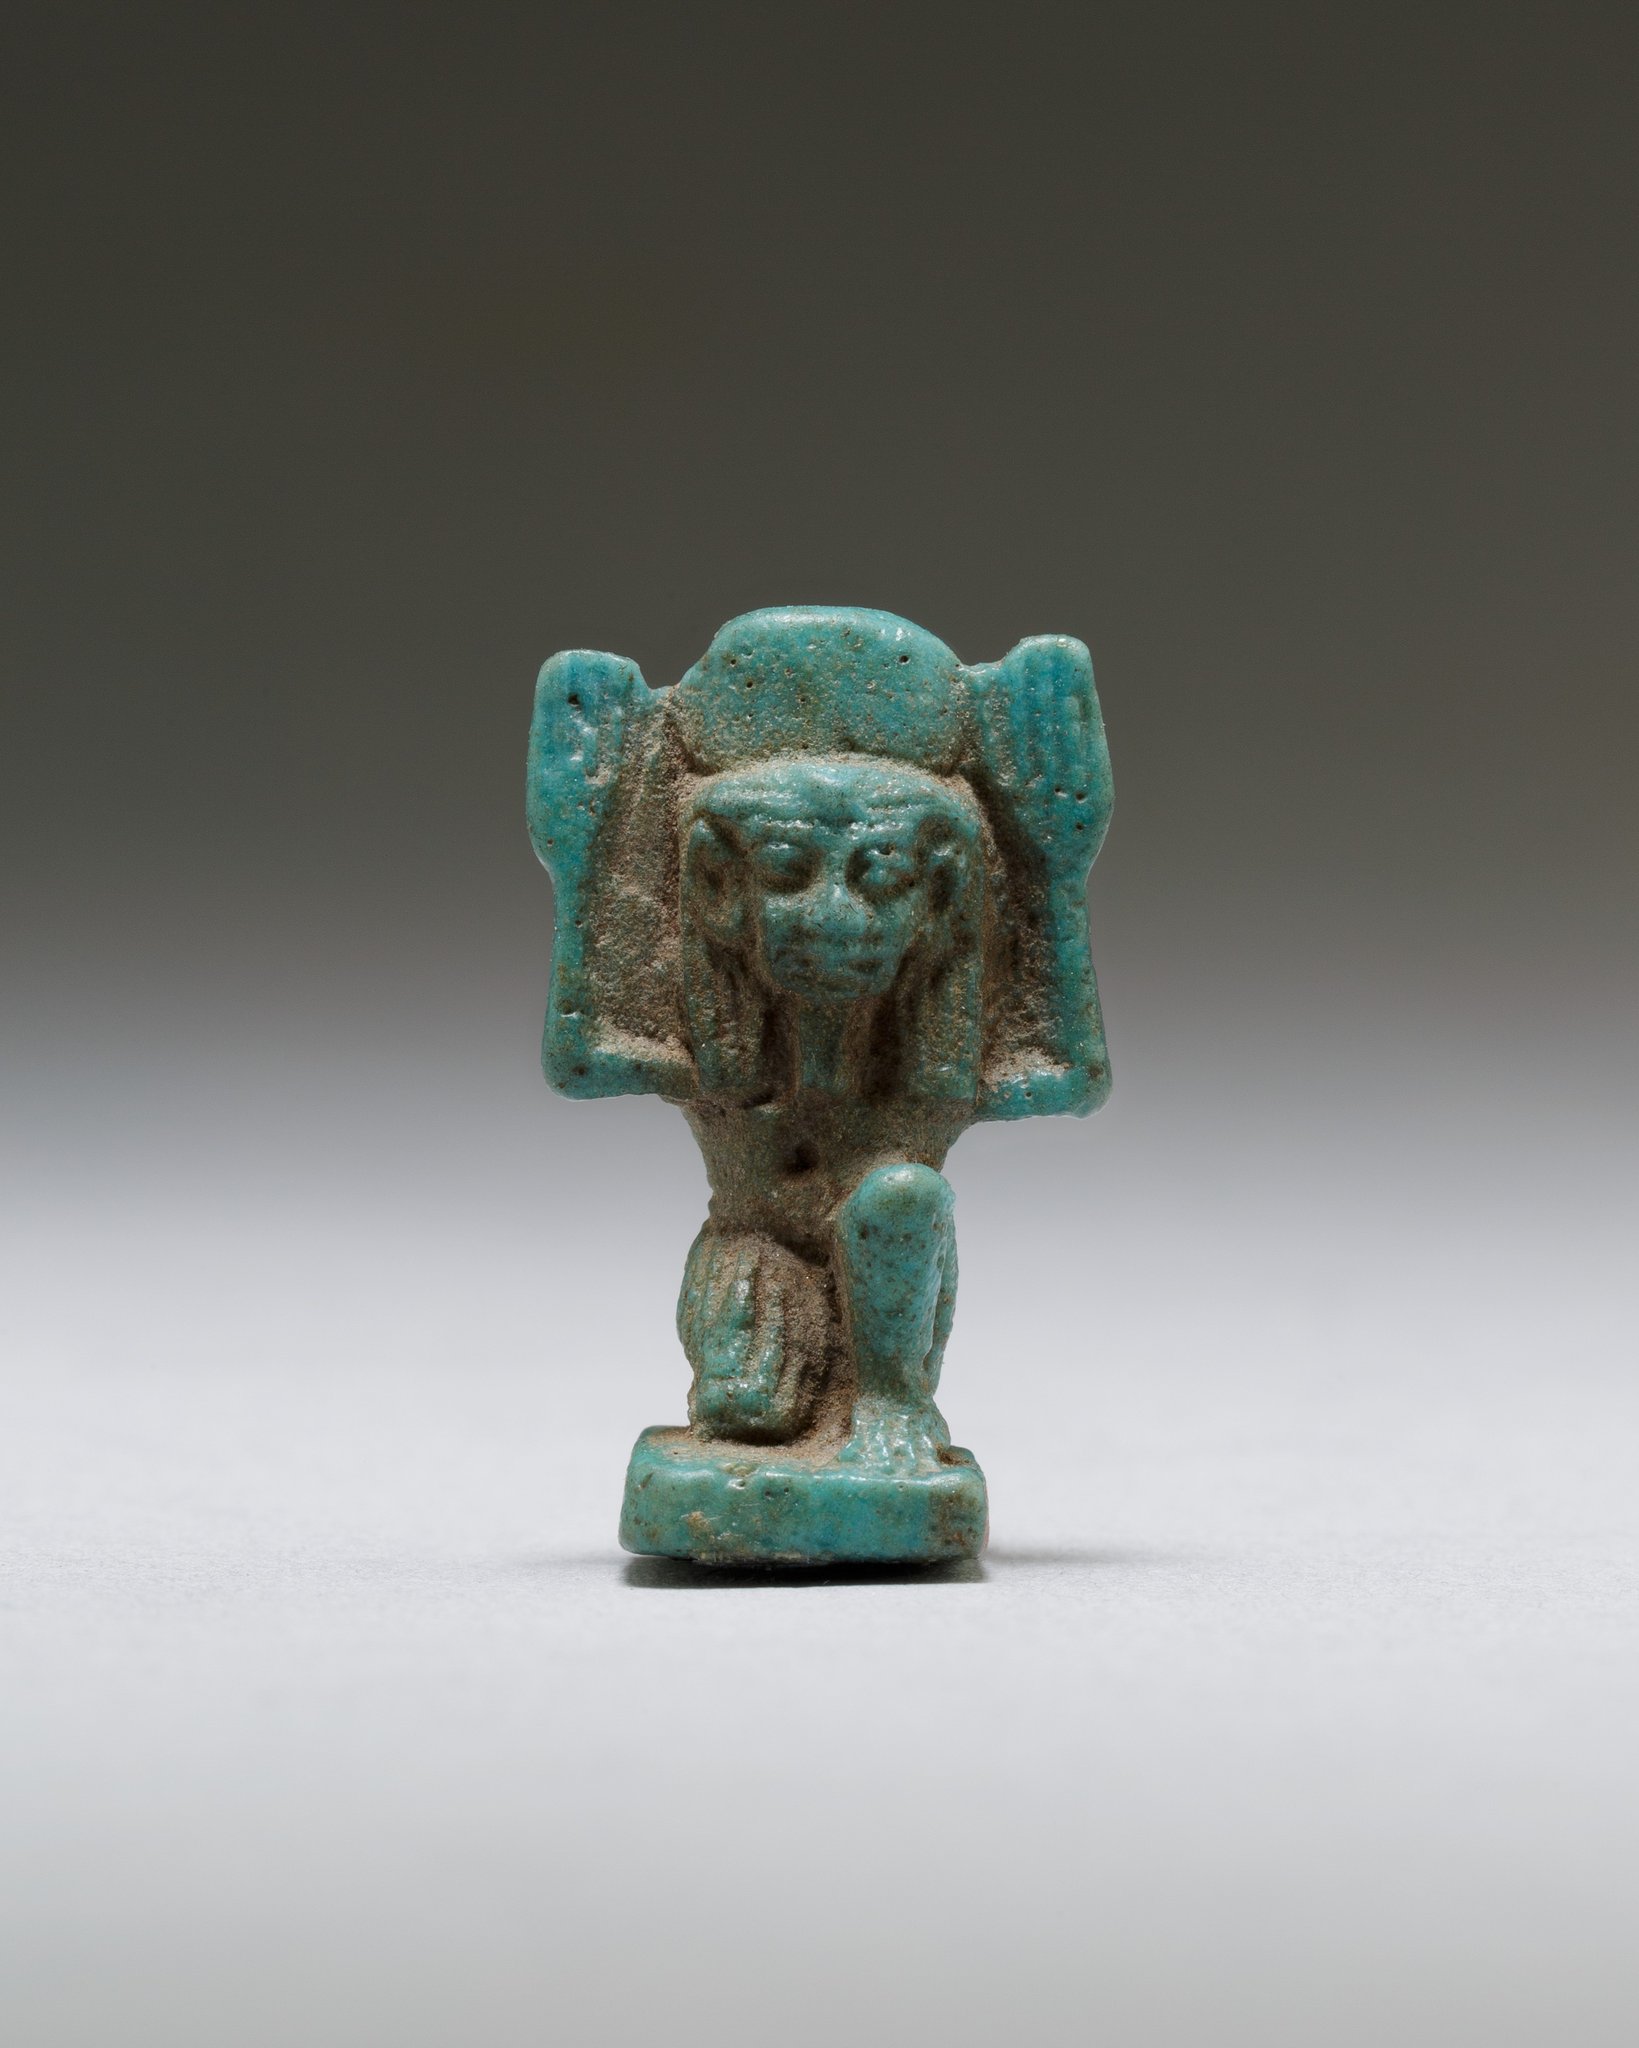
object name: amulet, shu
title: Shu amulet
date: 664-332 BCE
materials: faience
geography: egypt